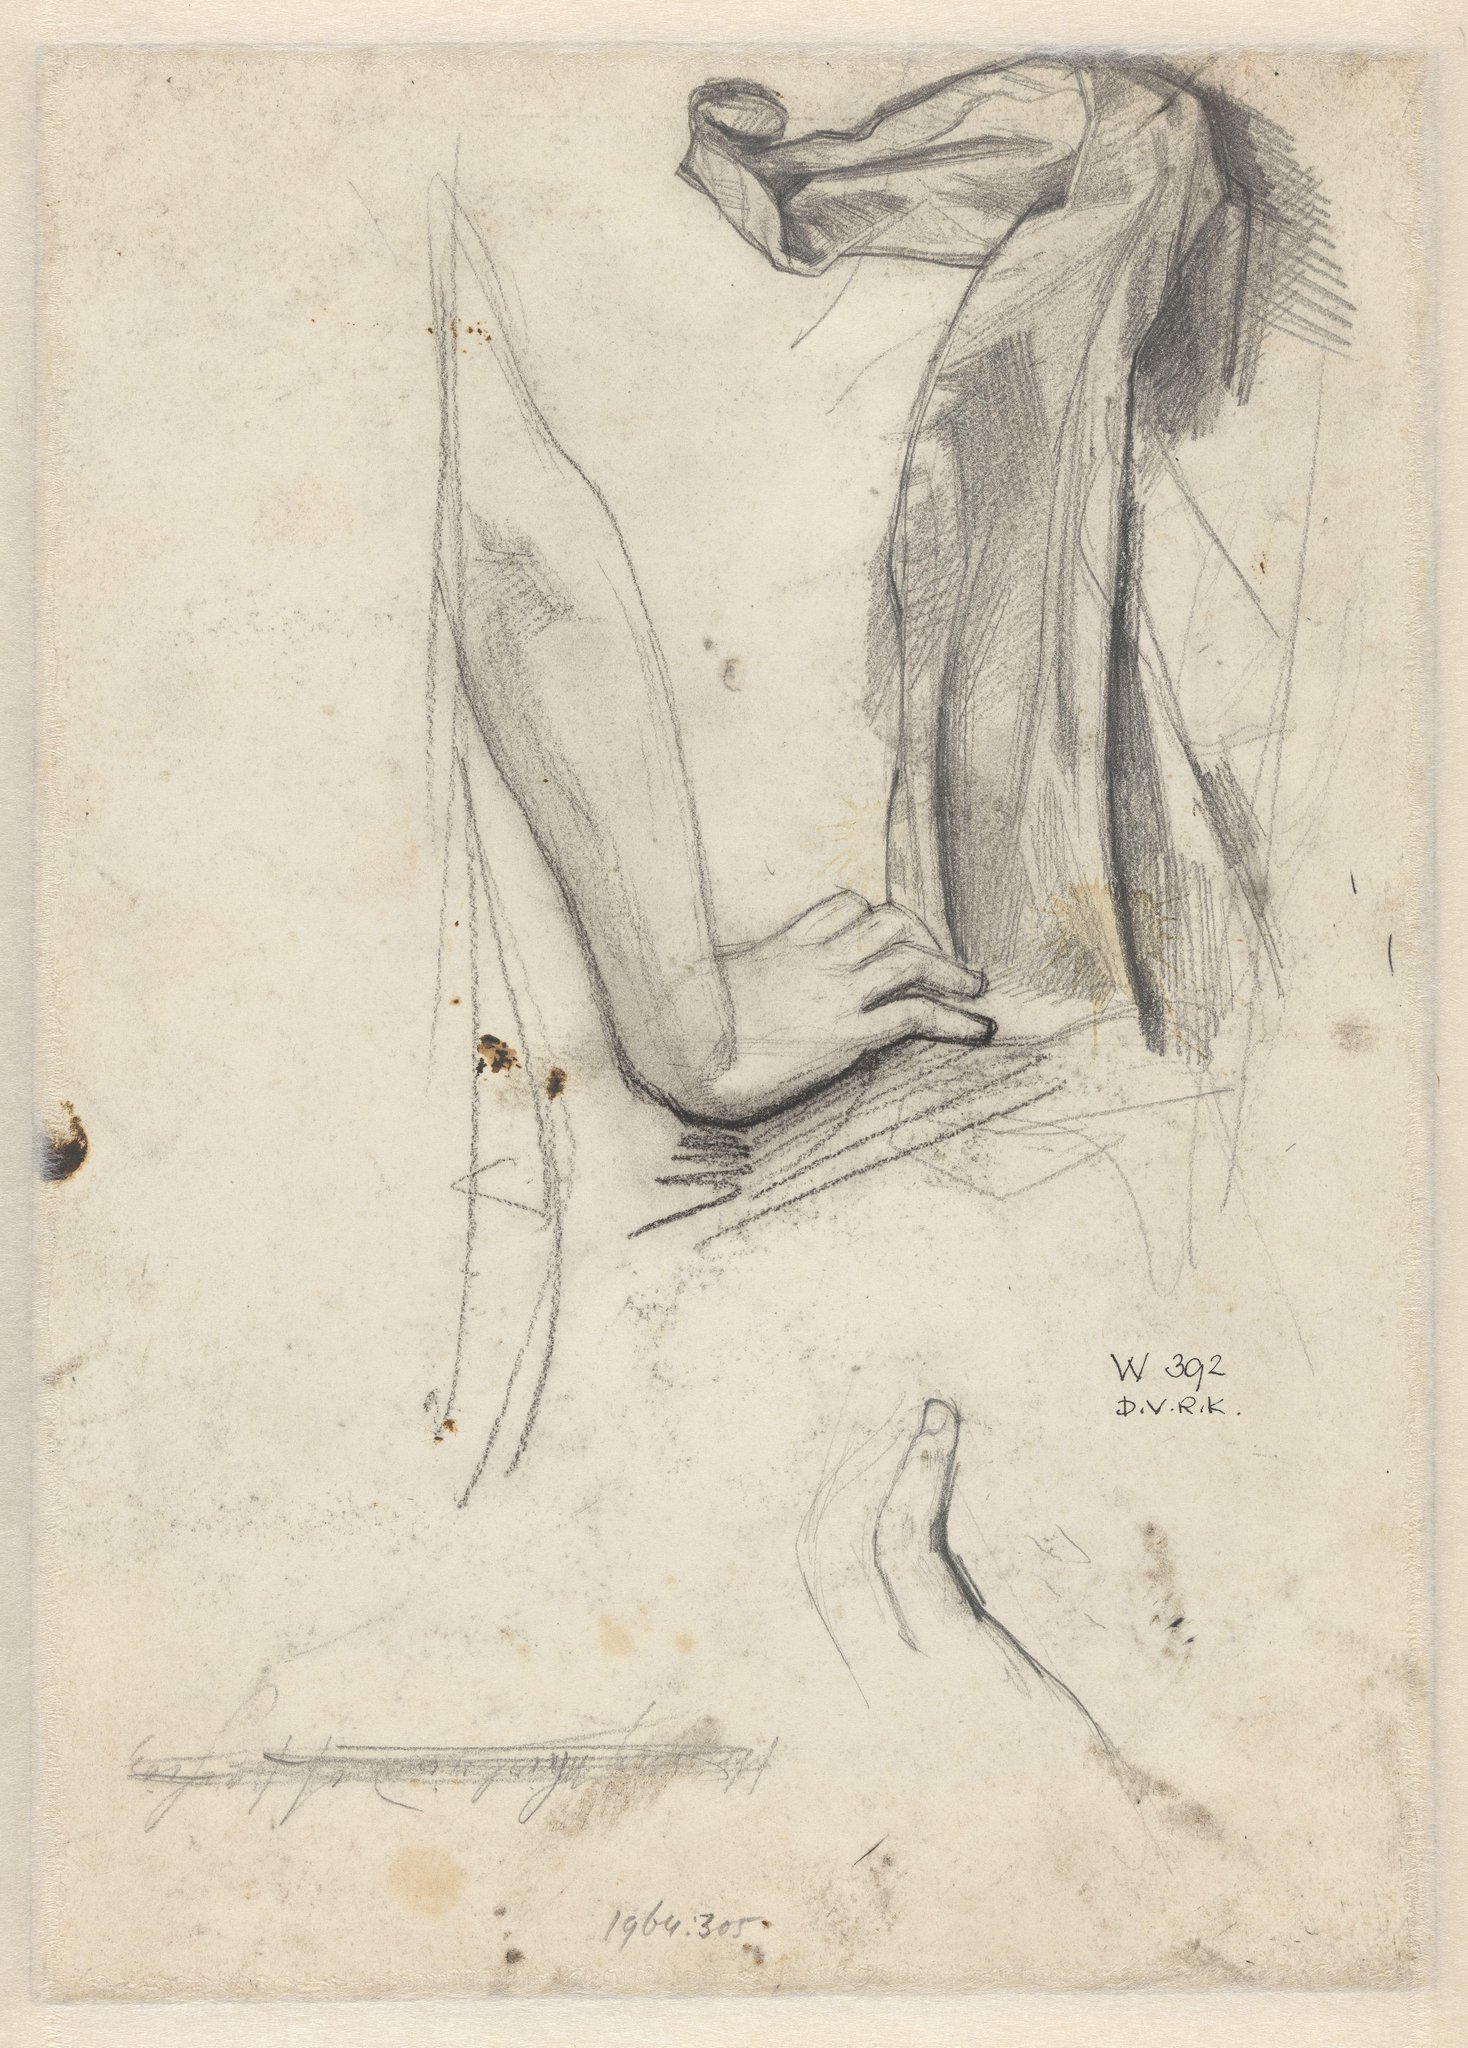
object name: drawing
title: Compositie van draperie en arm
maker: willem witsen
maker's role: draughtsman, painter, print maker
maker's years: 1860-1923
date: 1870-1923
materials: chalk, paper, pencil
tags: drapery, draped garment, 'gewandgebung'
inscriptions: inscription: ‘Een [...]’